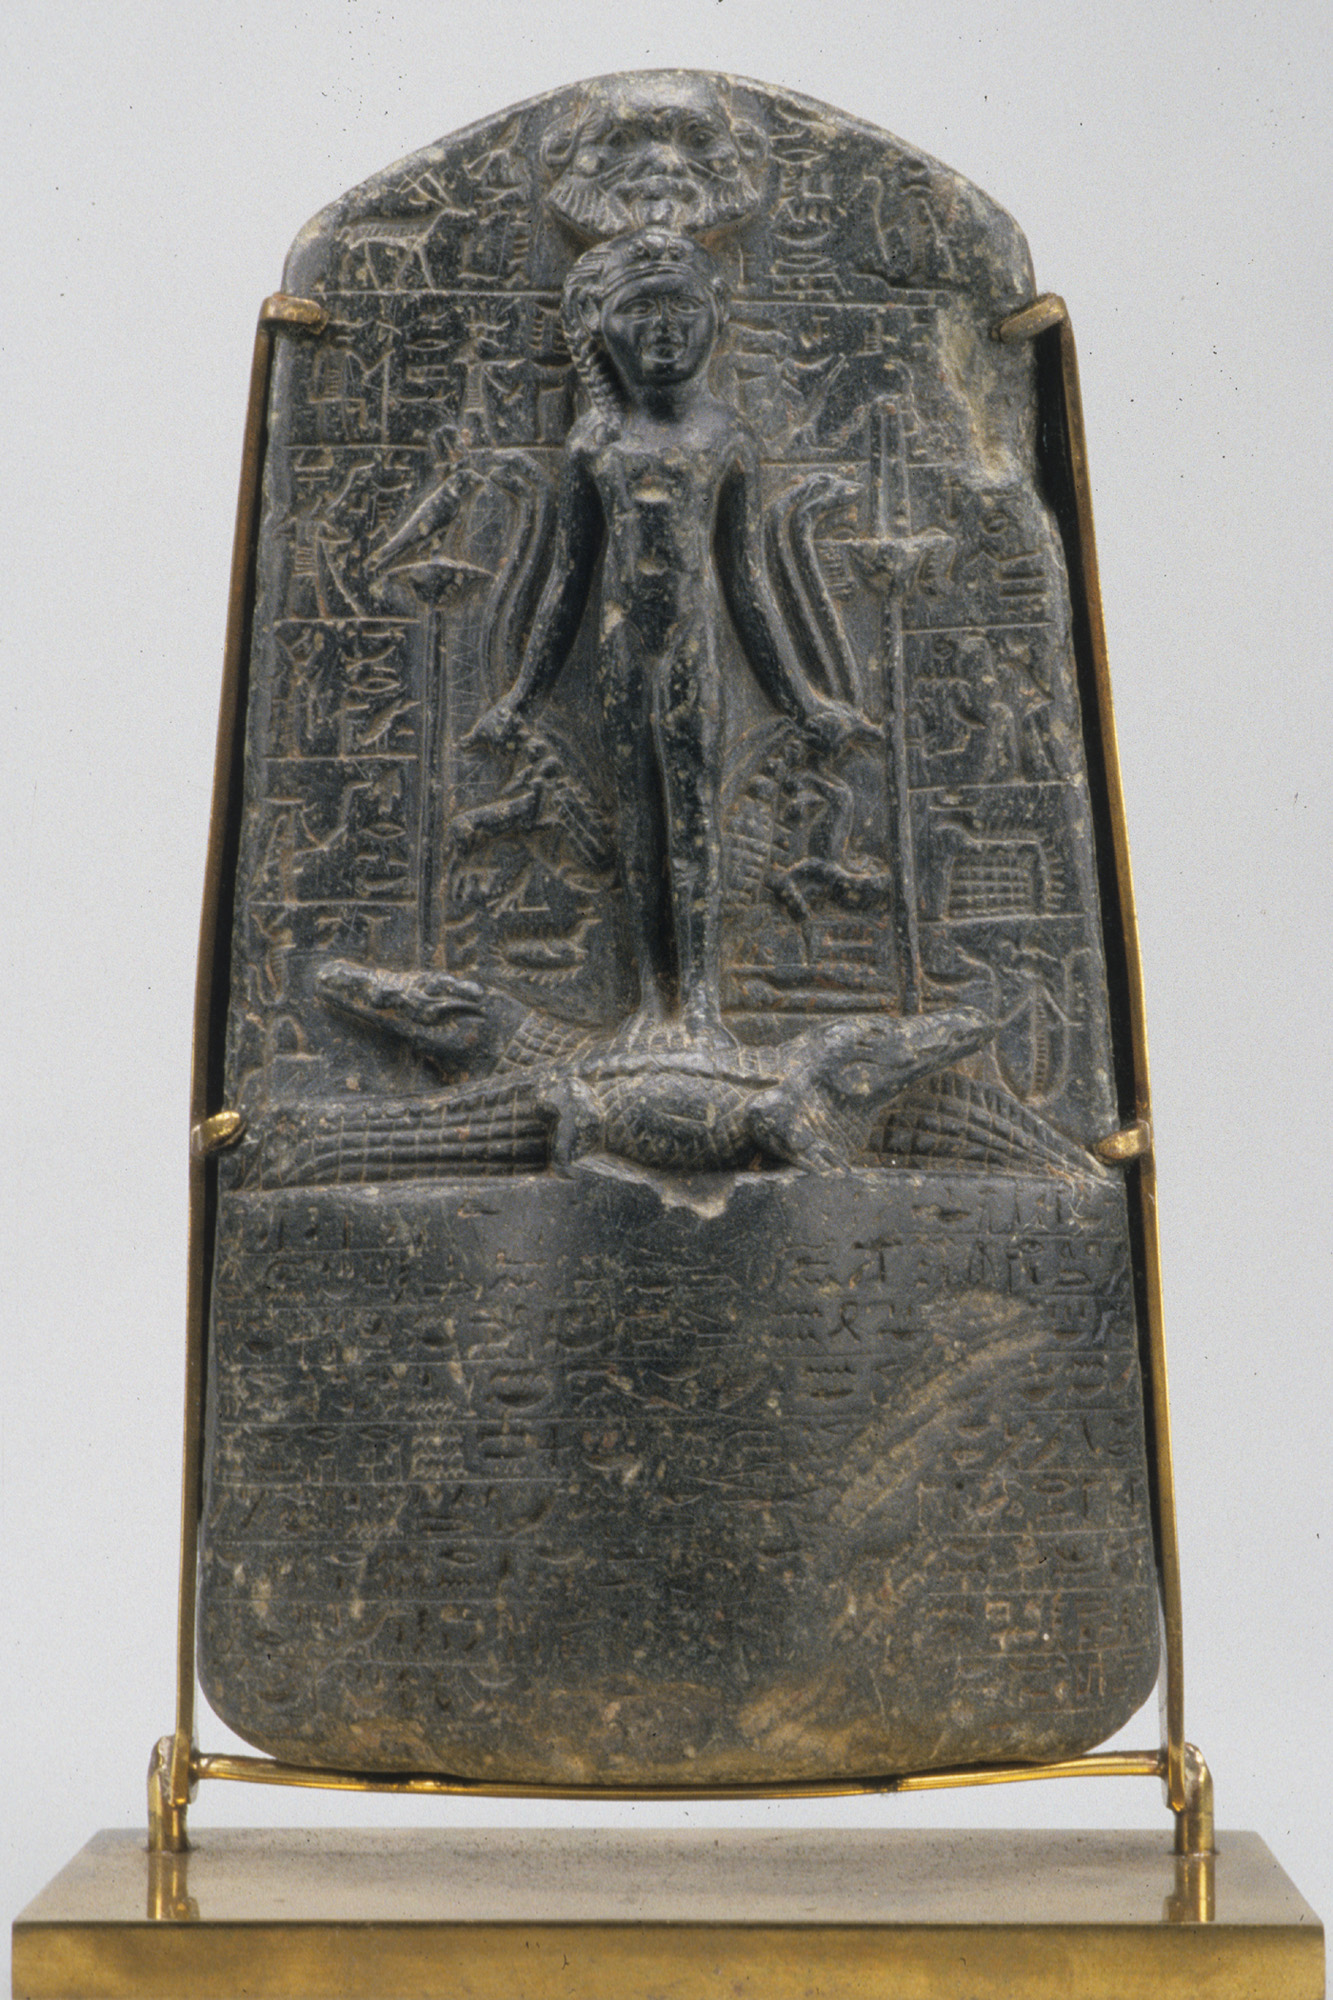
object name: cippus, horus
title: Cippus (magical stela)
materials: stone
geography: egypt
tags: bes,horus,crocodiles